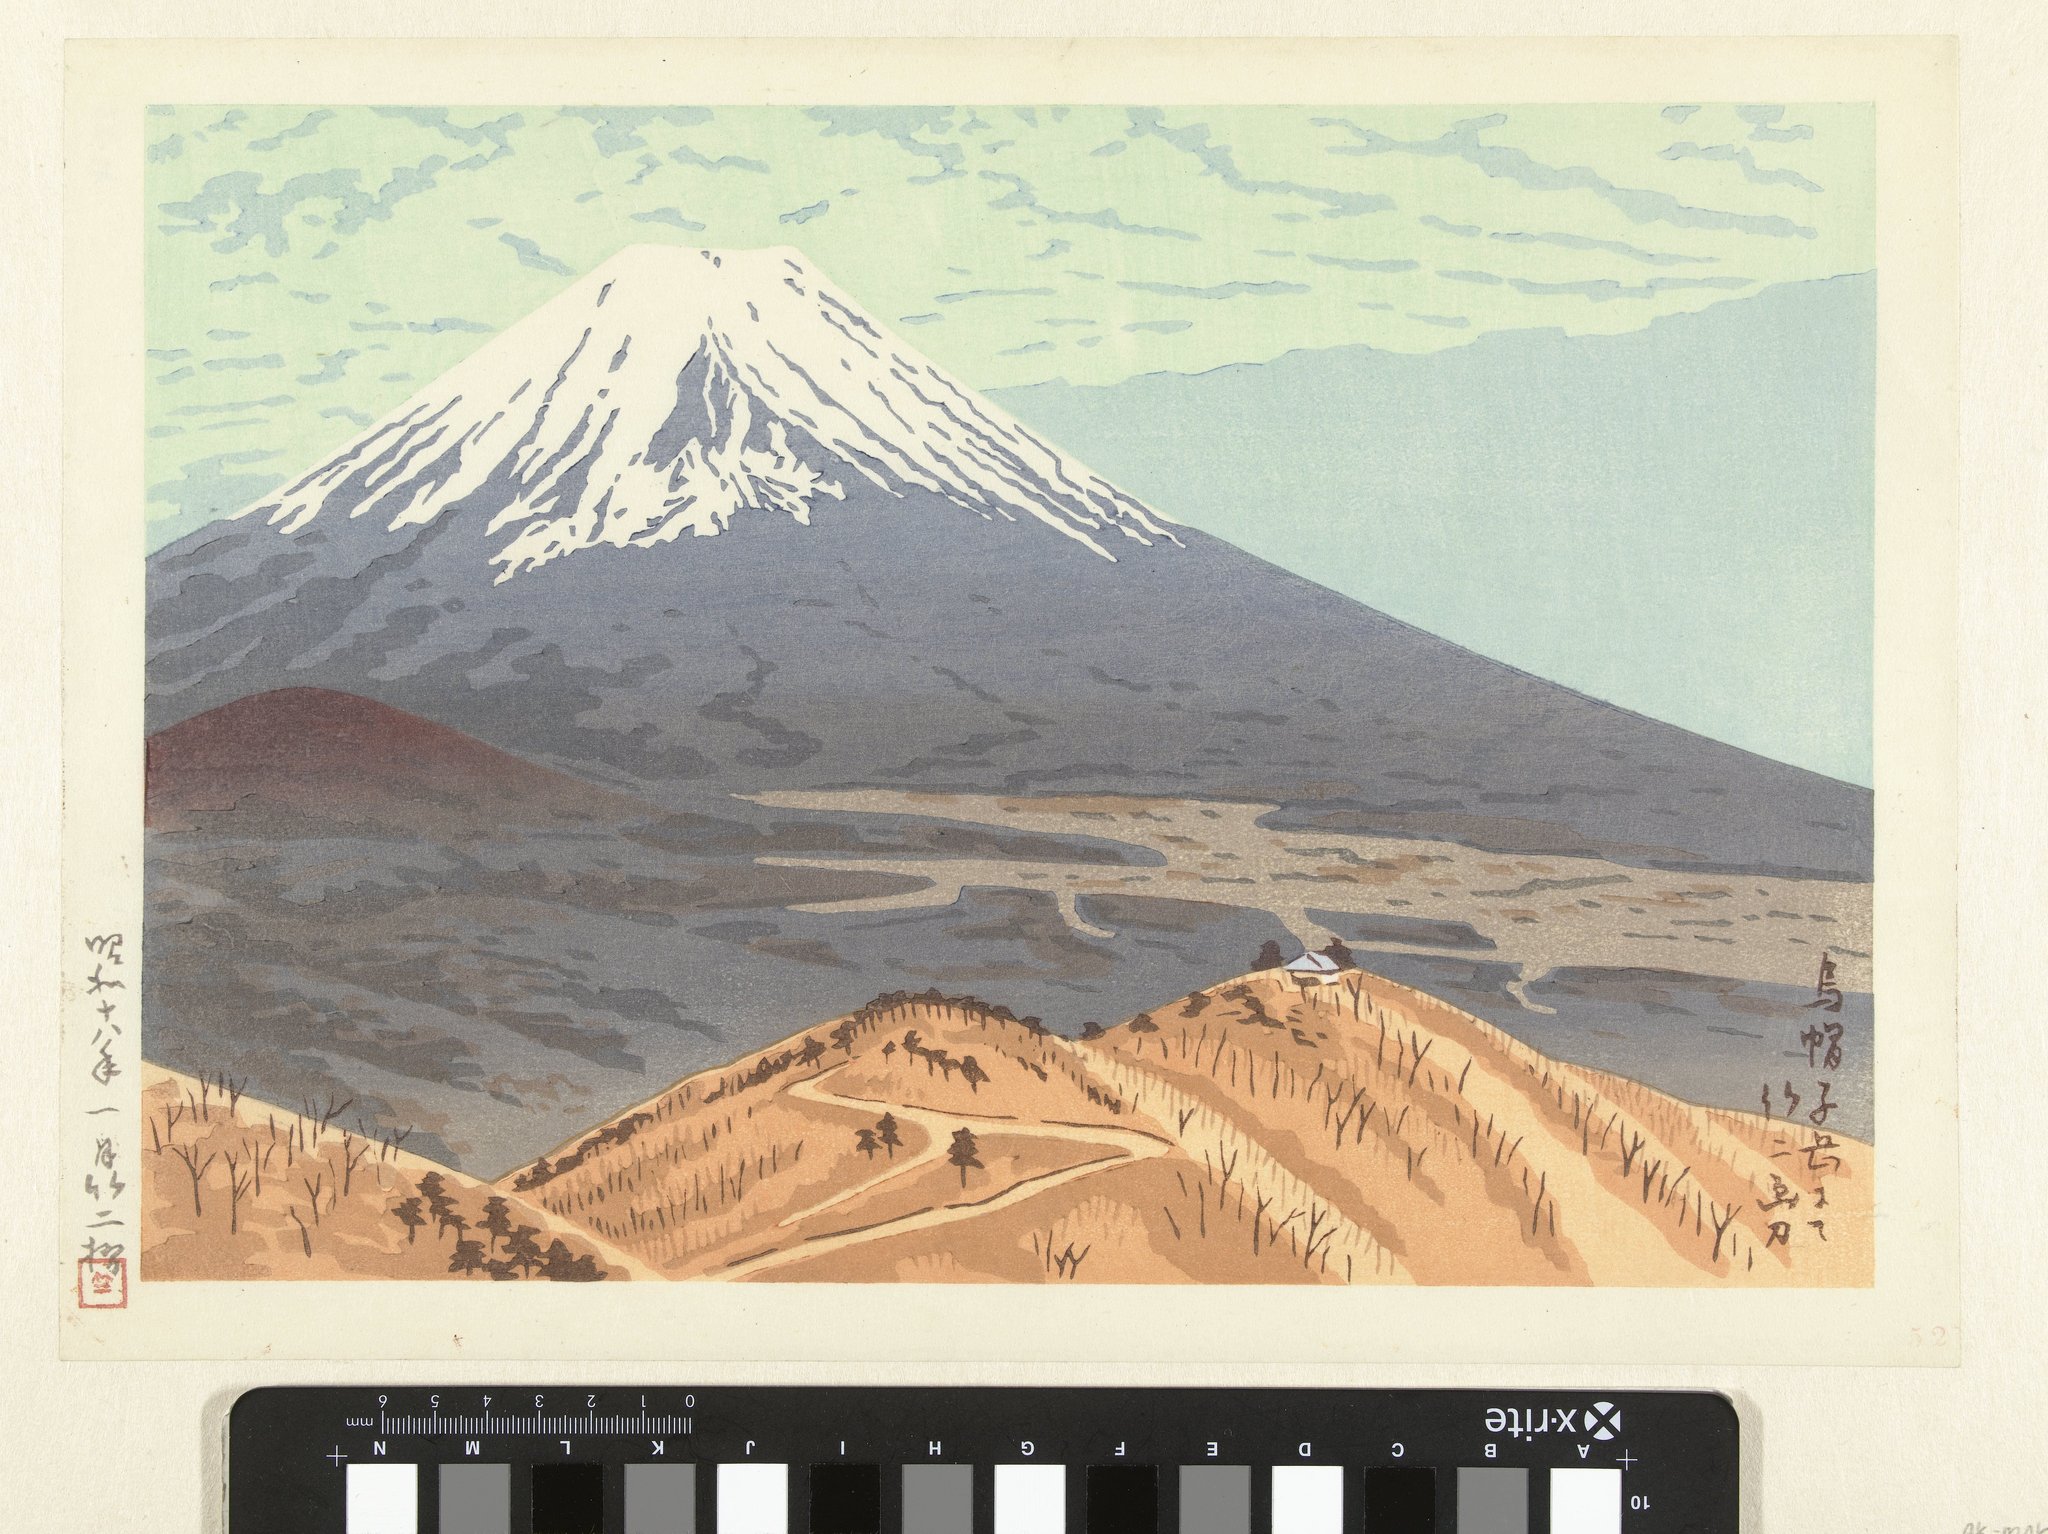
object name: print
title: Berglandschap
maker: yamaguchi susumu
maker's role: print maker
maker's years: 1897-1982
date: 1901-1943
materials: paper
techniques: woodcut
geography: japan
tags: mountains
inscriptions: date